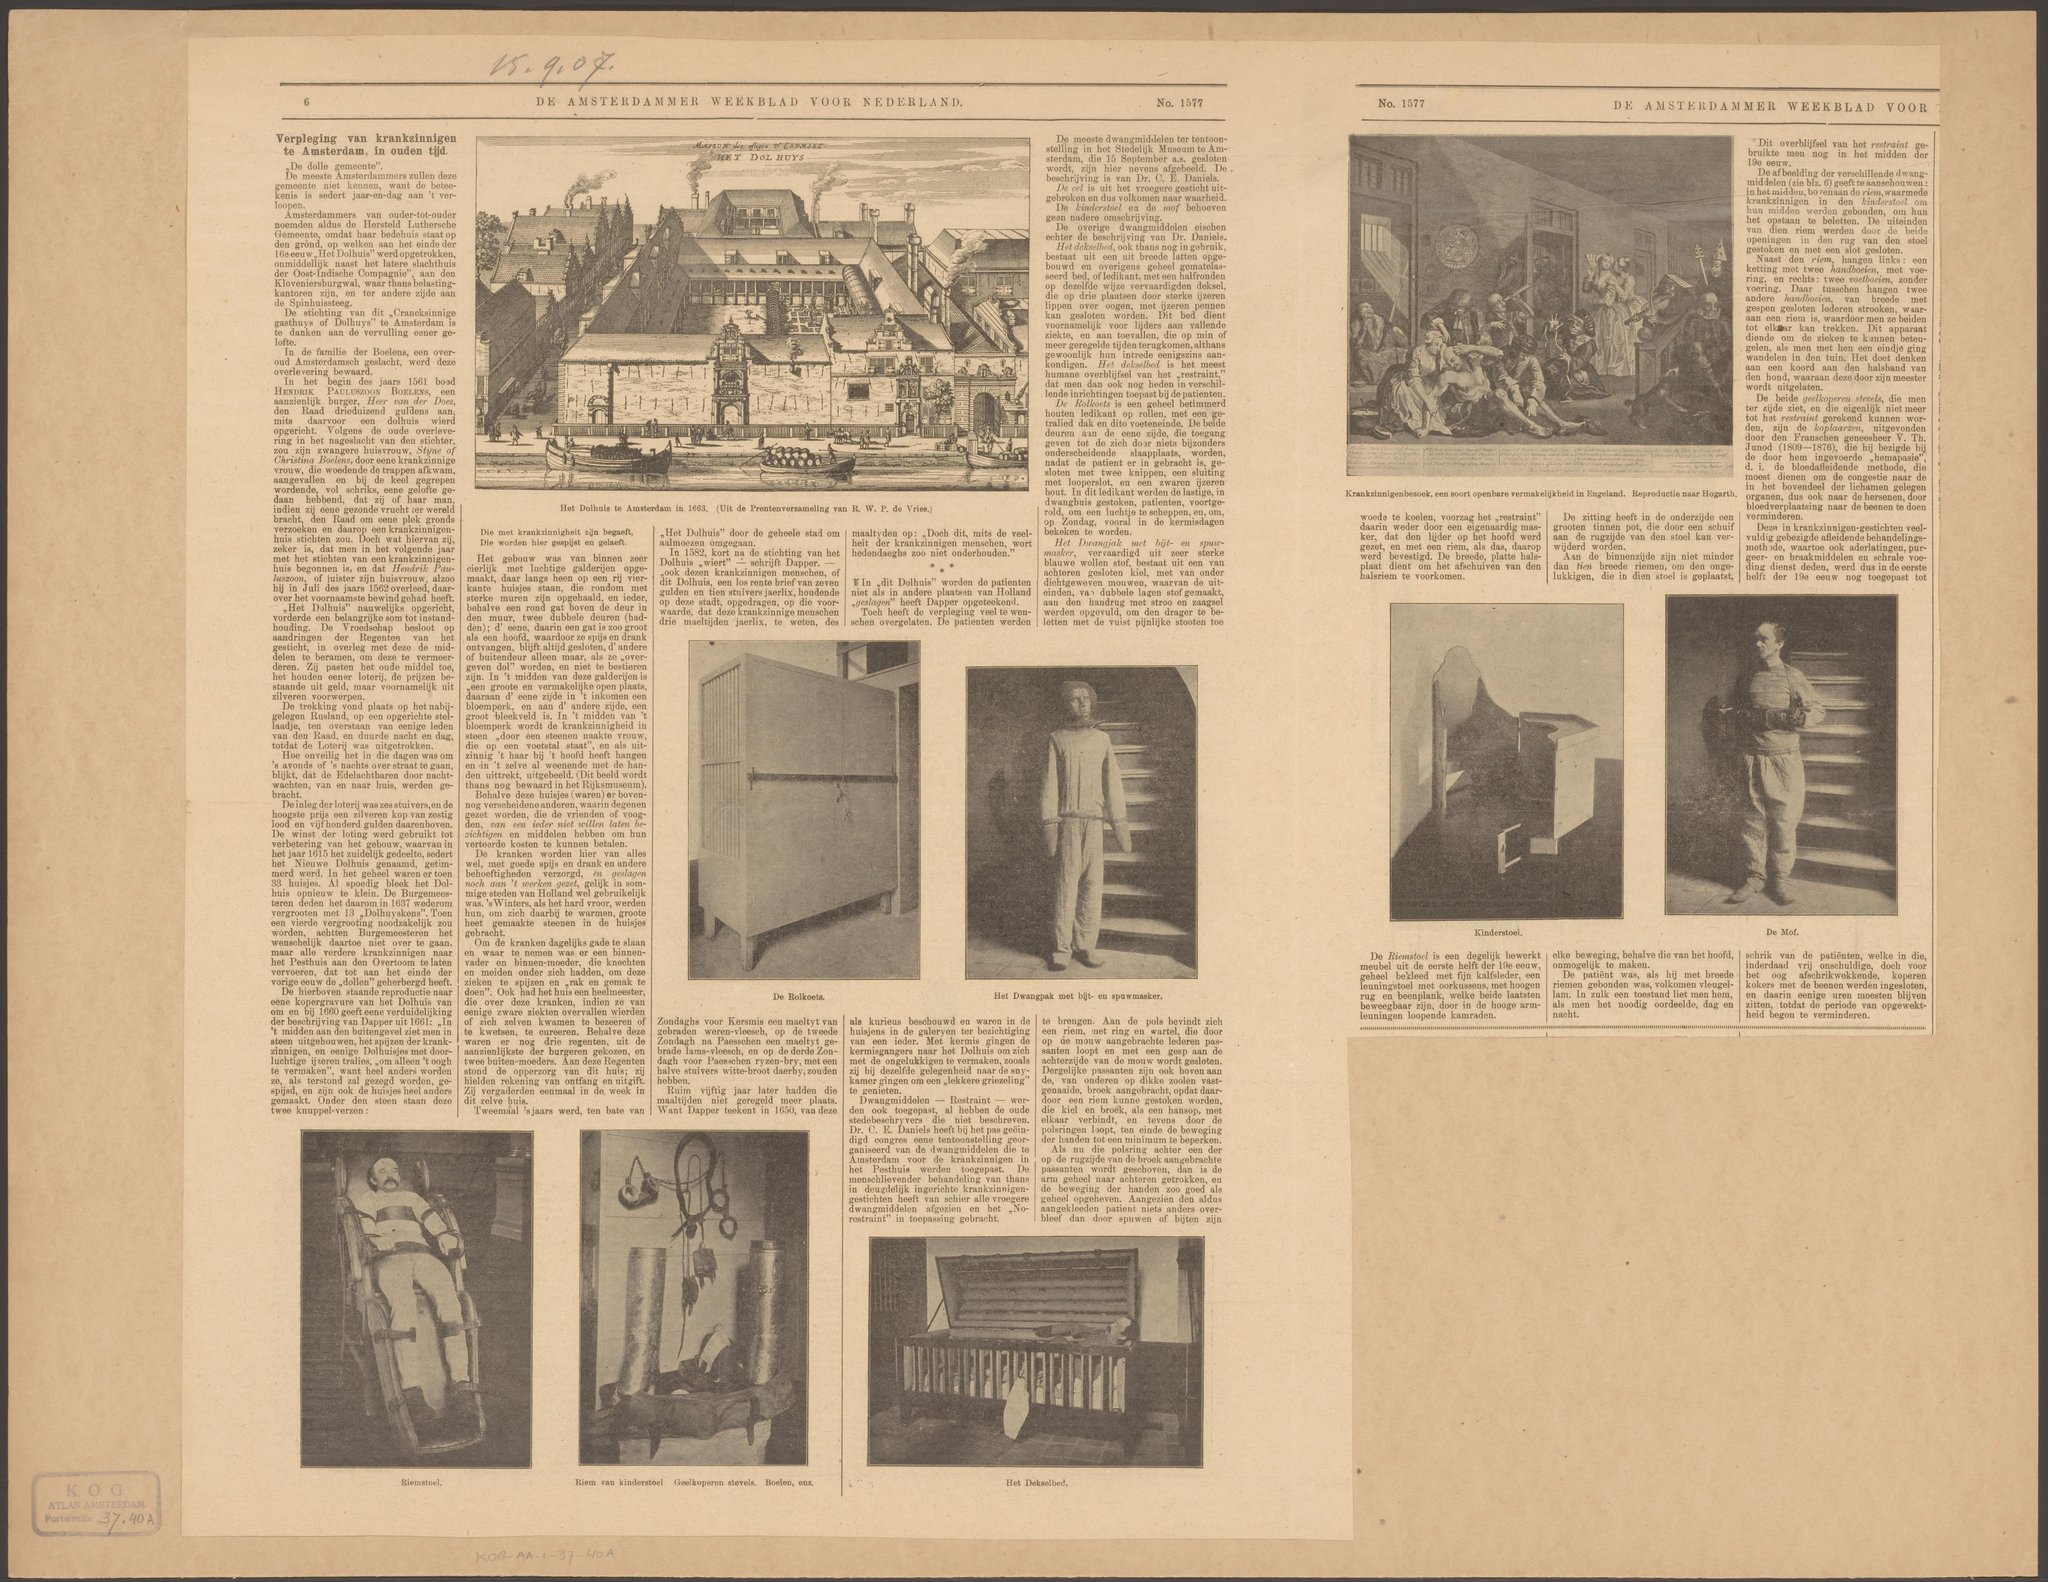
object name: article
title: Verpleging van krankzinnigen te Amsterdam, in ouden tijd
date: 1907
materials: paper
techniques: letterpress printing, line block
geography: amsterdam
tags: lunatic asylum, mental home, dolhuis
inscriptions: collector's mark: Lugt 1641b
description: Onderwerpsrubriek binnen de Atlas Amsterdam: Armwezen en liefdadige instellingen: I. Stadsinrichtingen: Dolhuis.